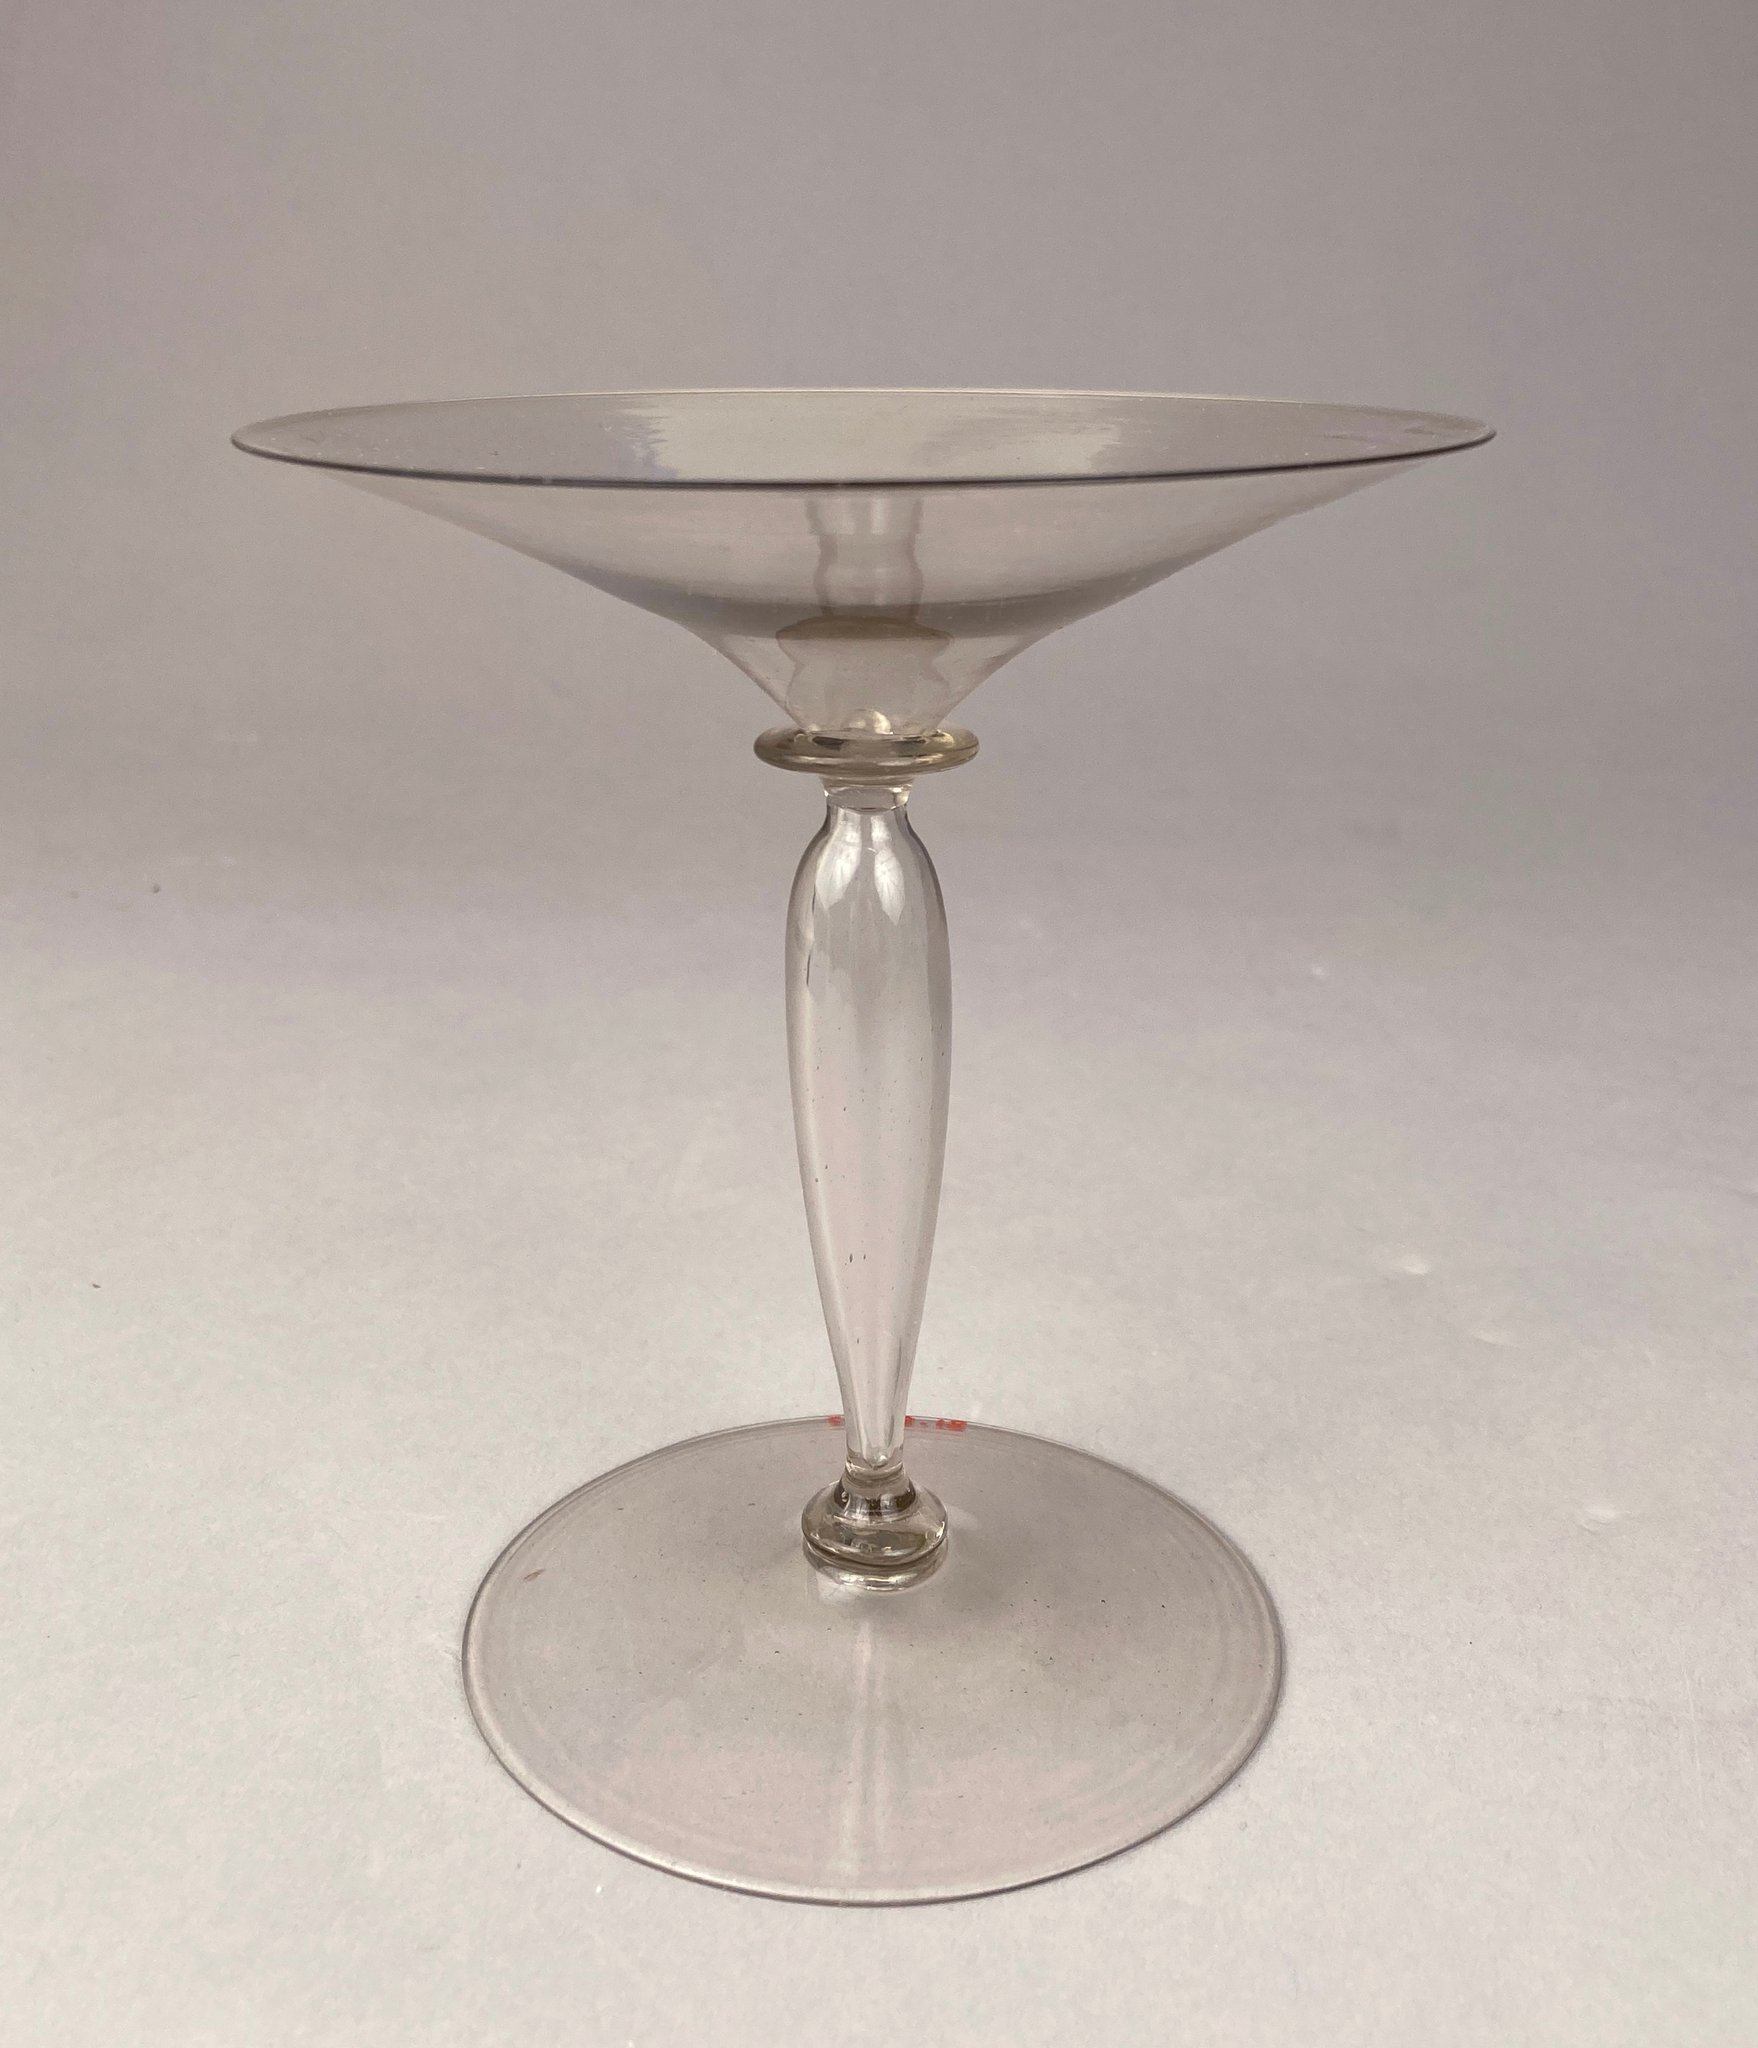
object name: wineglass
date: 1601-1700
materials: glass